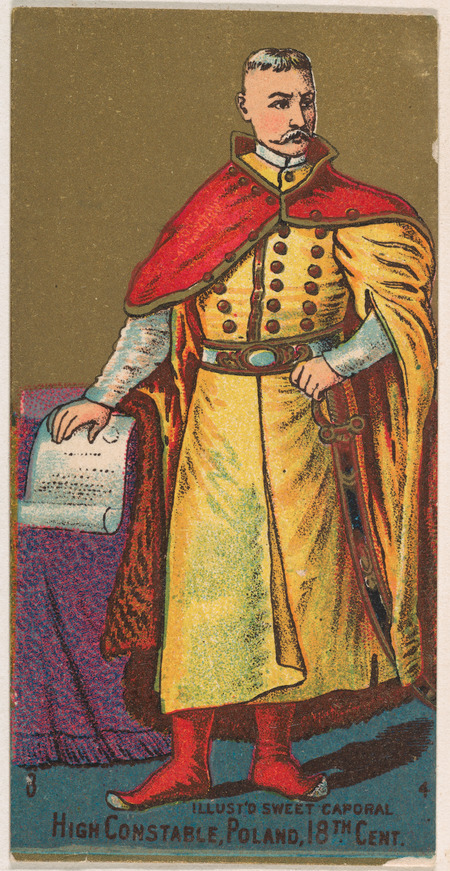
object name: print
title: High Constable, Poland, 18th Century, from the Military Series (N224) issued by Kinney Tobacco Company to promote Sweet Caporal Cigarettes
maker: kinney brothers tobacco company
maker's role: publisher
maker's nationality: american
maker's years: 1869-2011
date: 1888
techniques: color lithograph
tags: military,men